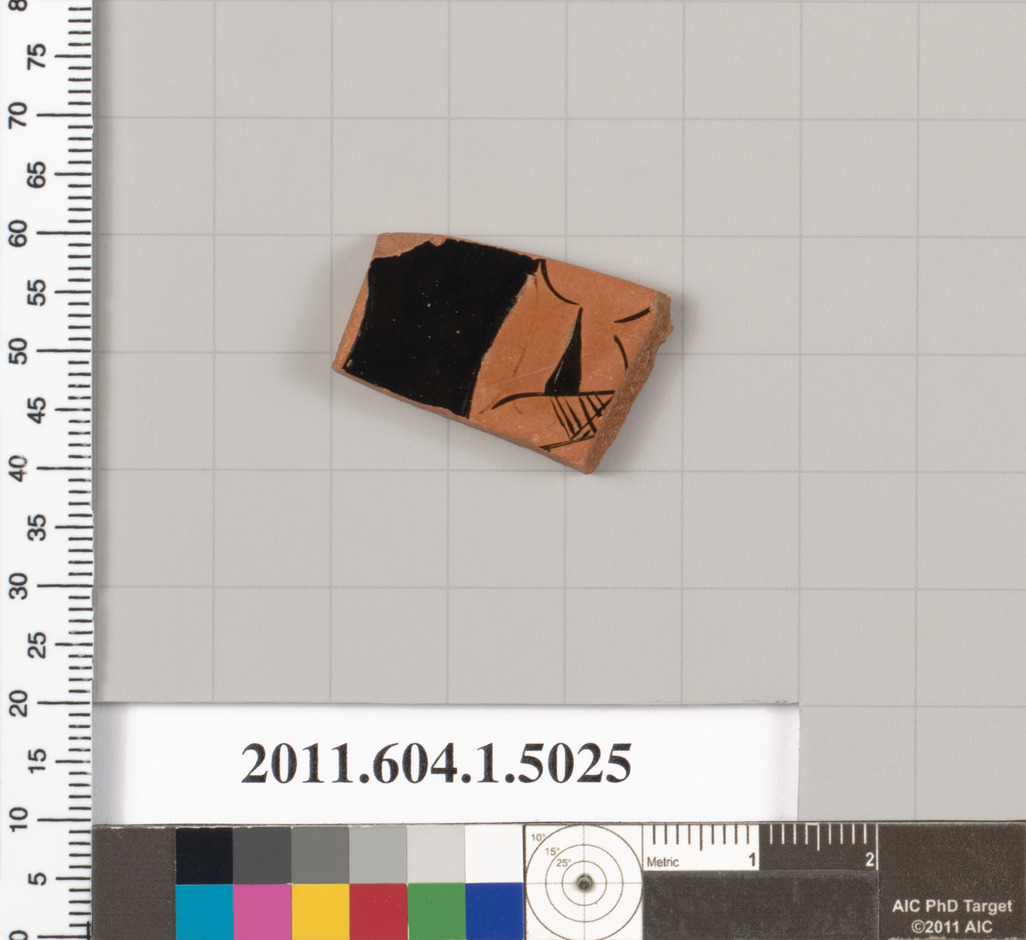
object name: kylix fragment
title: Terracotta fragment of a kylix (drinking cup)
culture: greek, attic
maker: thorvaldsen group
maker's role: artist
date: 490-480 BCE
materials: terracotta